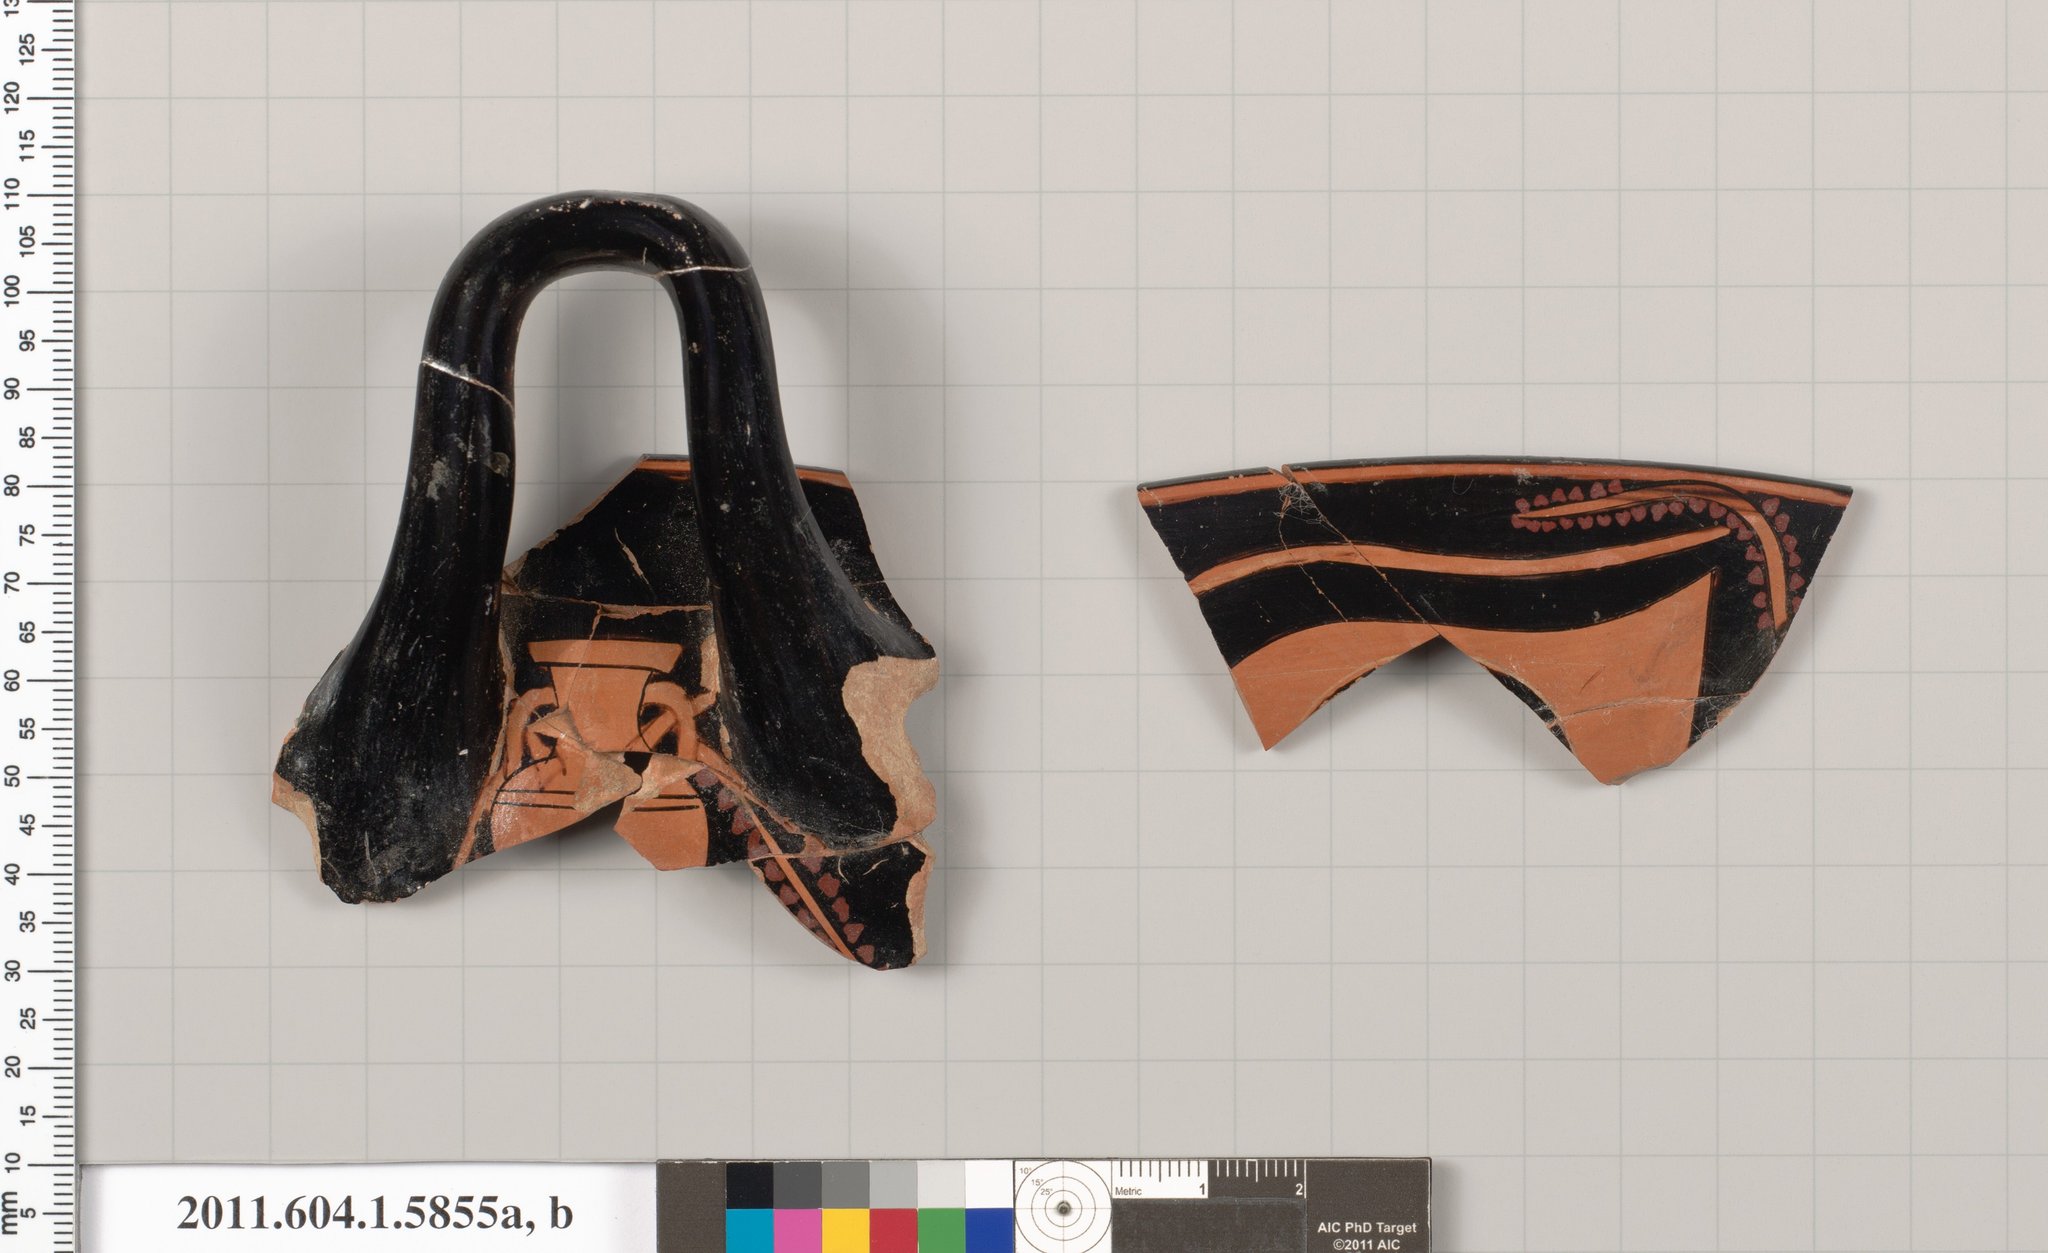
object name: kylix fragment, eye cup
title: Terracotta fragments of a kylix: eye-cup (drinking cup)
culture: greek, attic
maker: andokides painter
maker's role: artist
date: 520 BCE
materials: terracotta